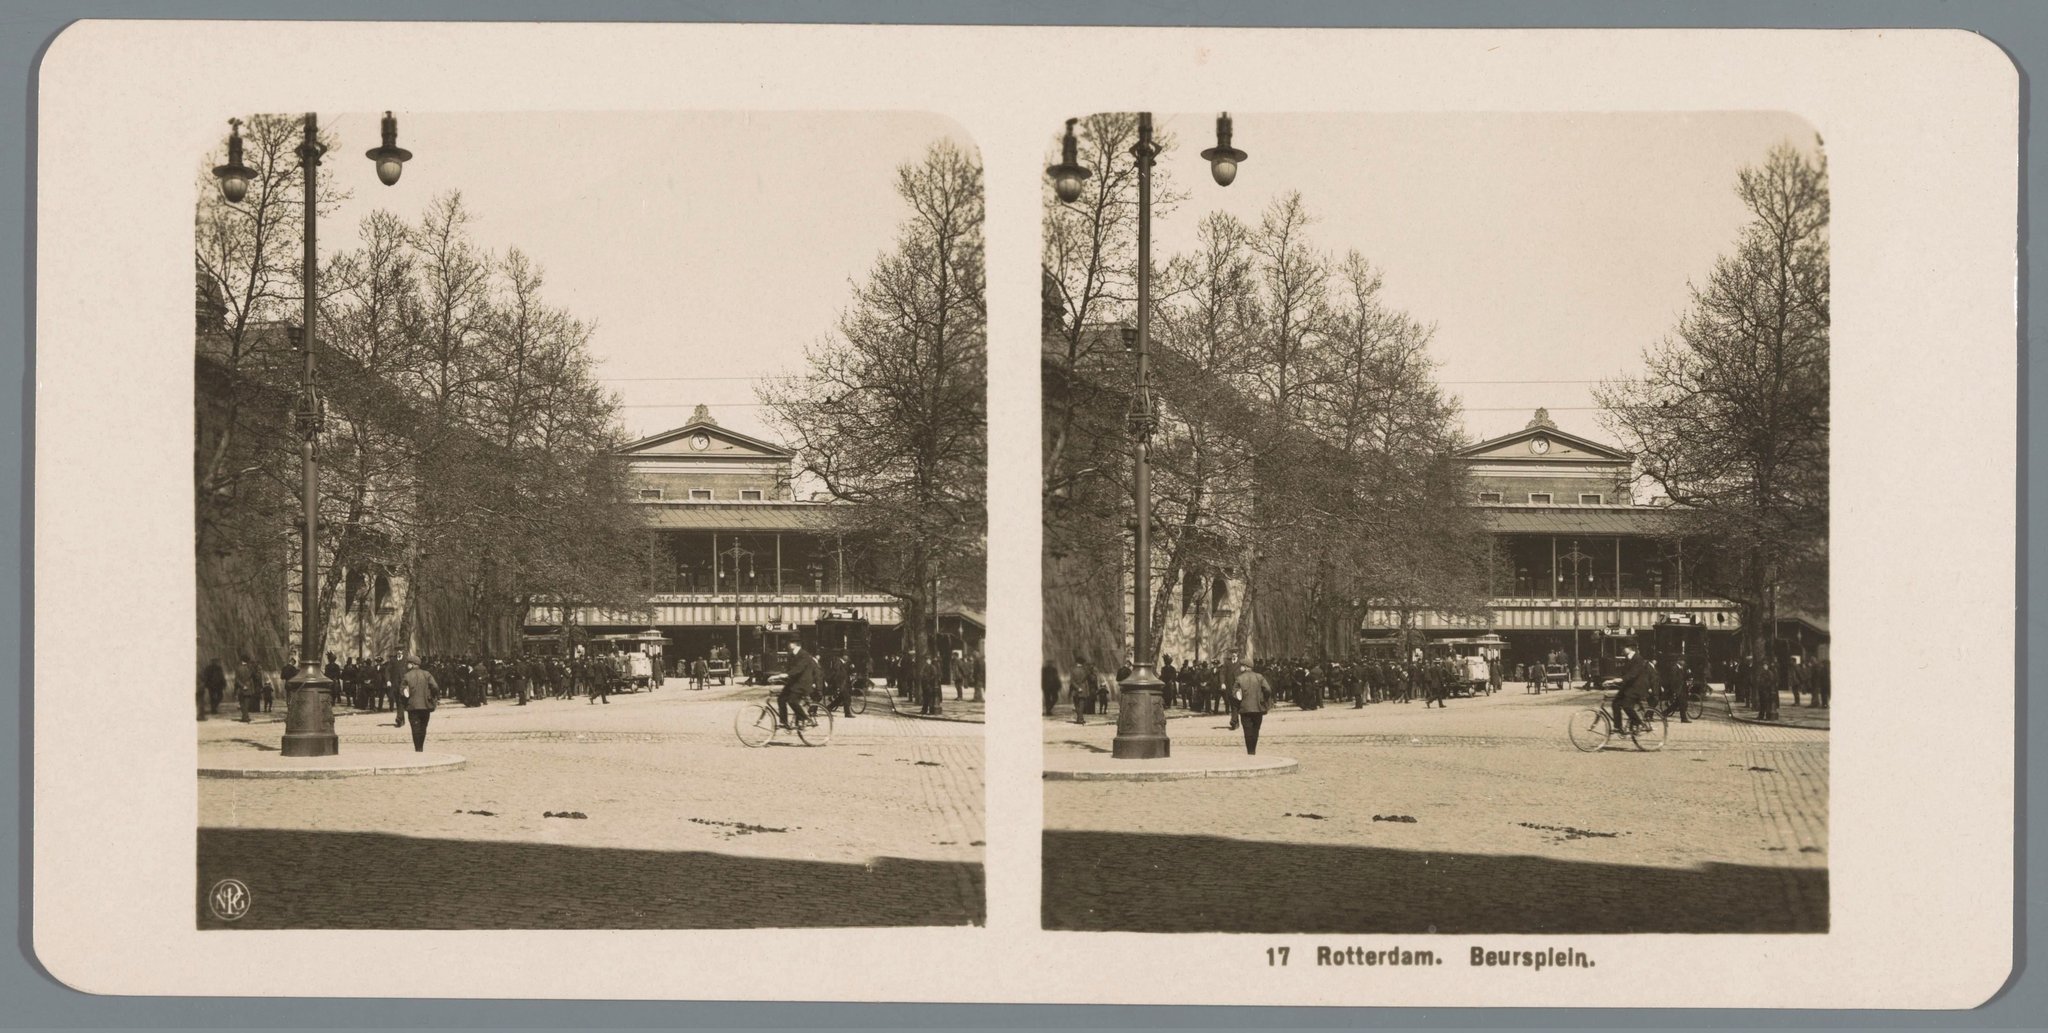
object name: stereograph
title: Rotterdam. Beursplein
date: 1900-1910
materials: cardboard, photographic support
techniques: gelatin silver print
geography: rotterdam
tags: stock exchange, stock-market, village square, place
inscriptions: number: ‘17’, inscription: ‘NPG’